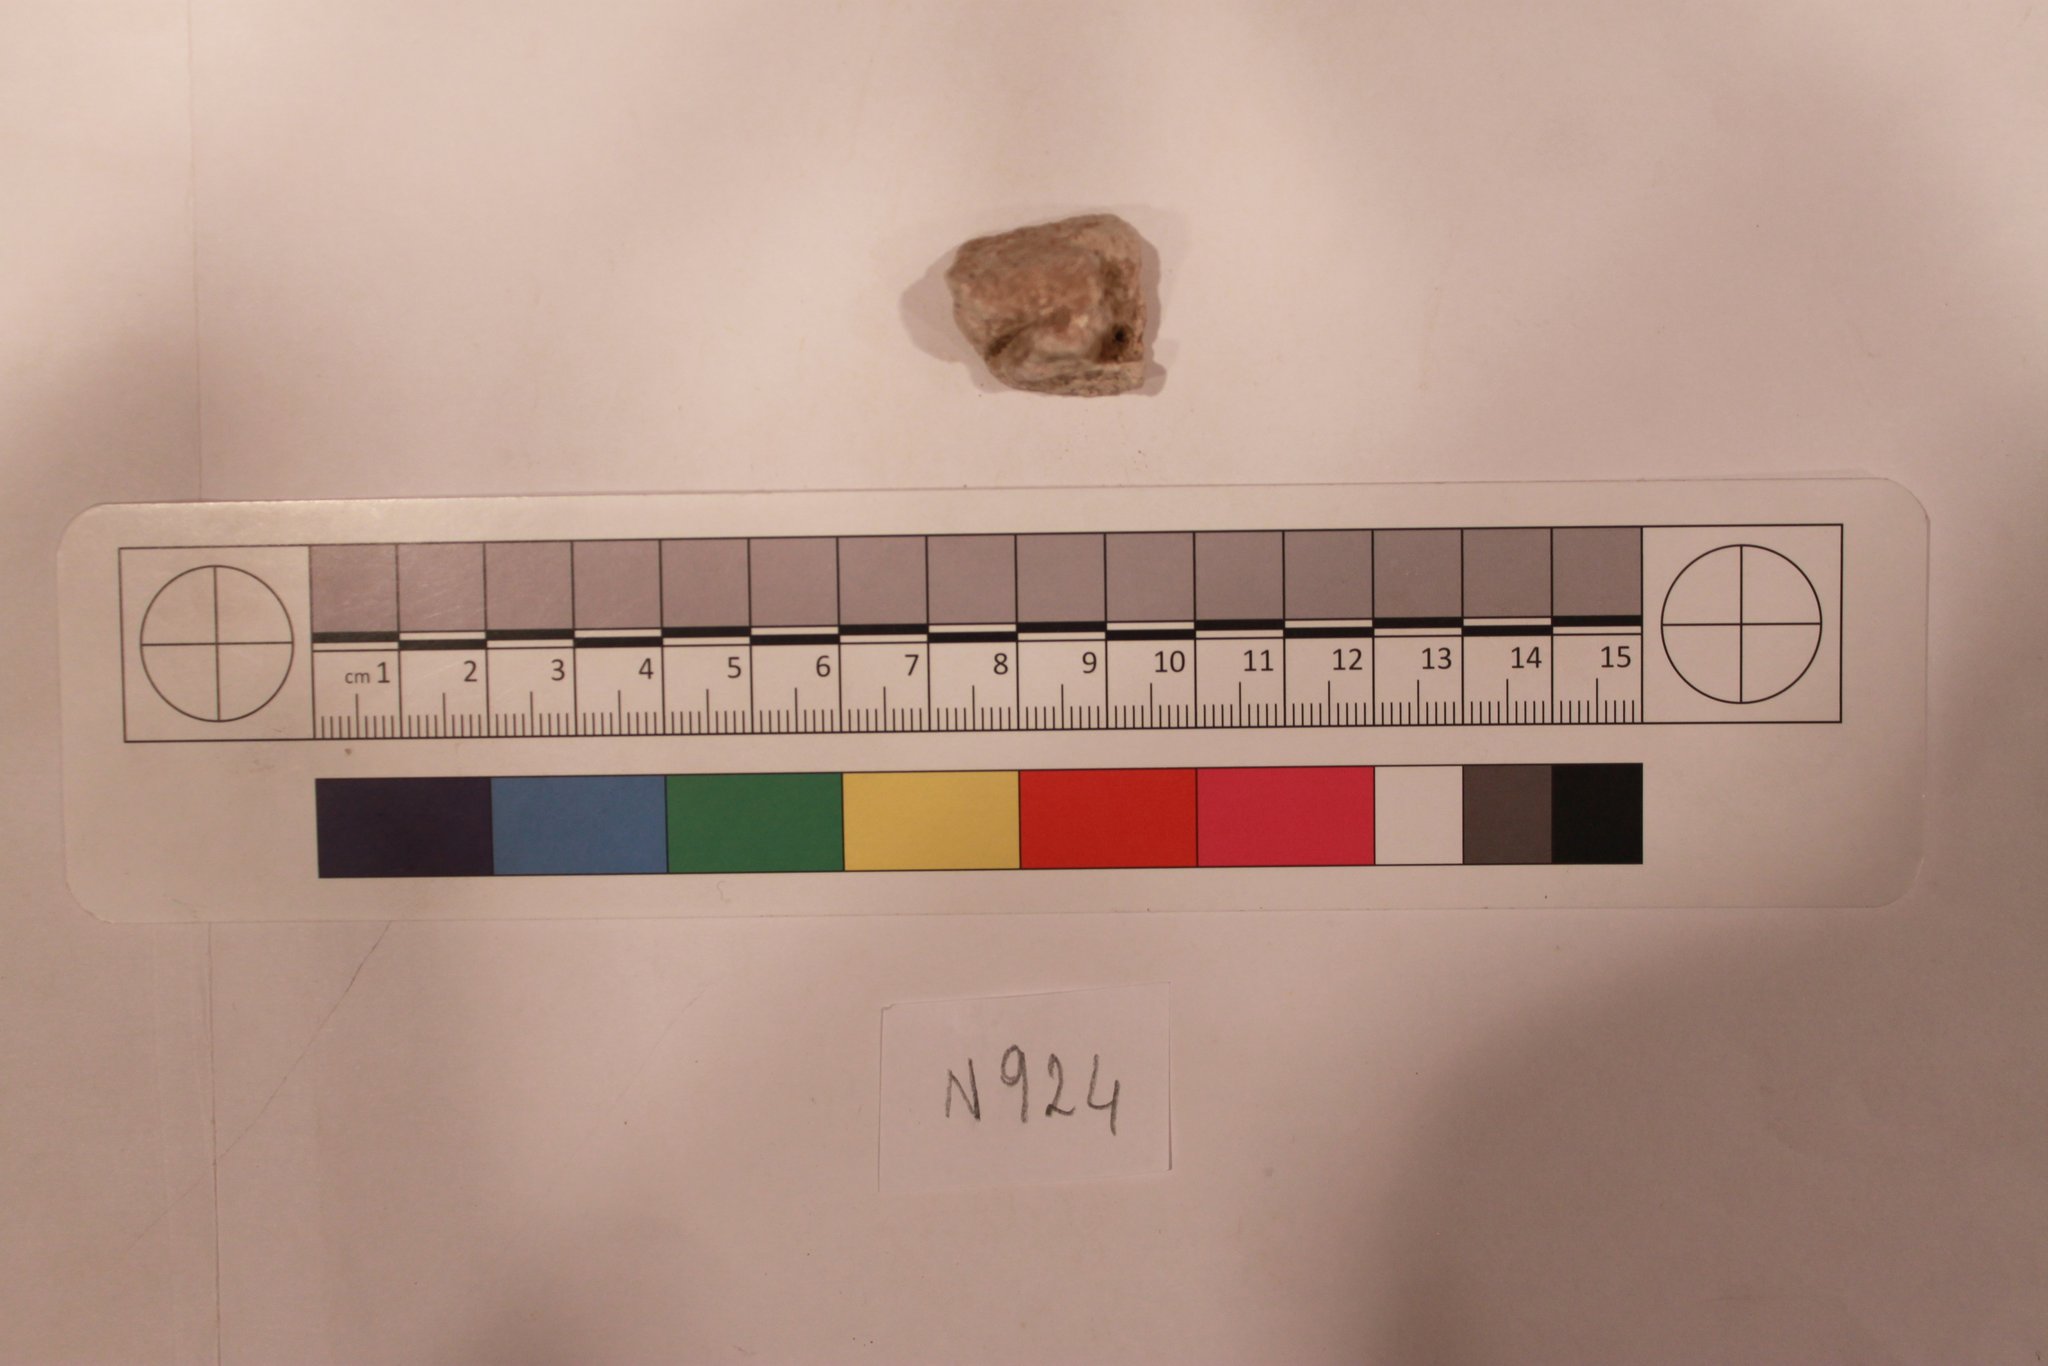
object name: fragment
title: Stucco Fragment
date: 701-1200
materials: plaster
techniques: carving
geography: iran